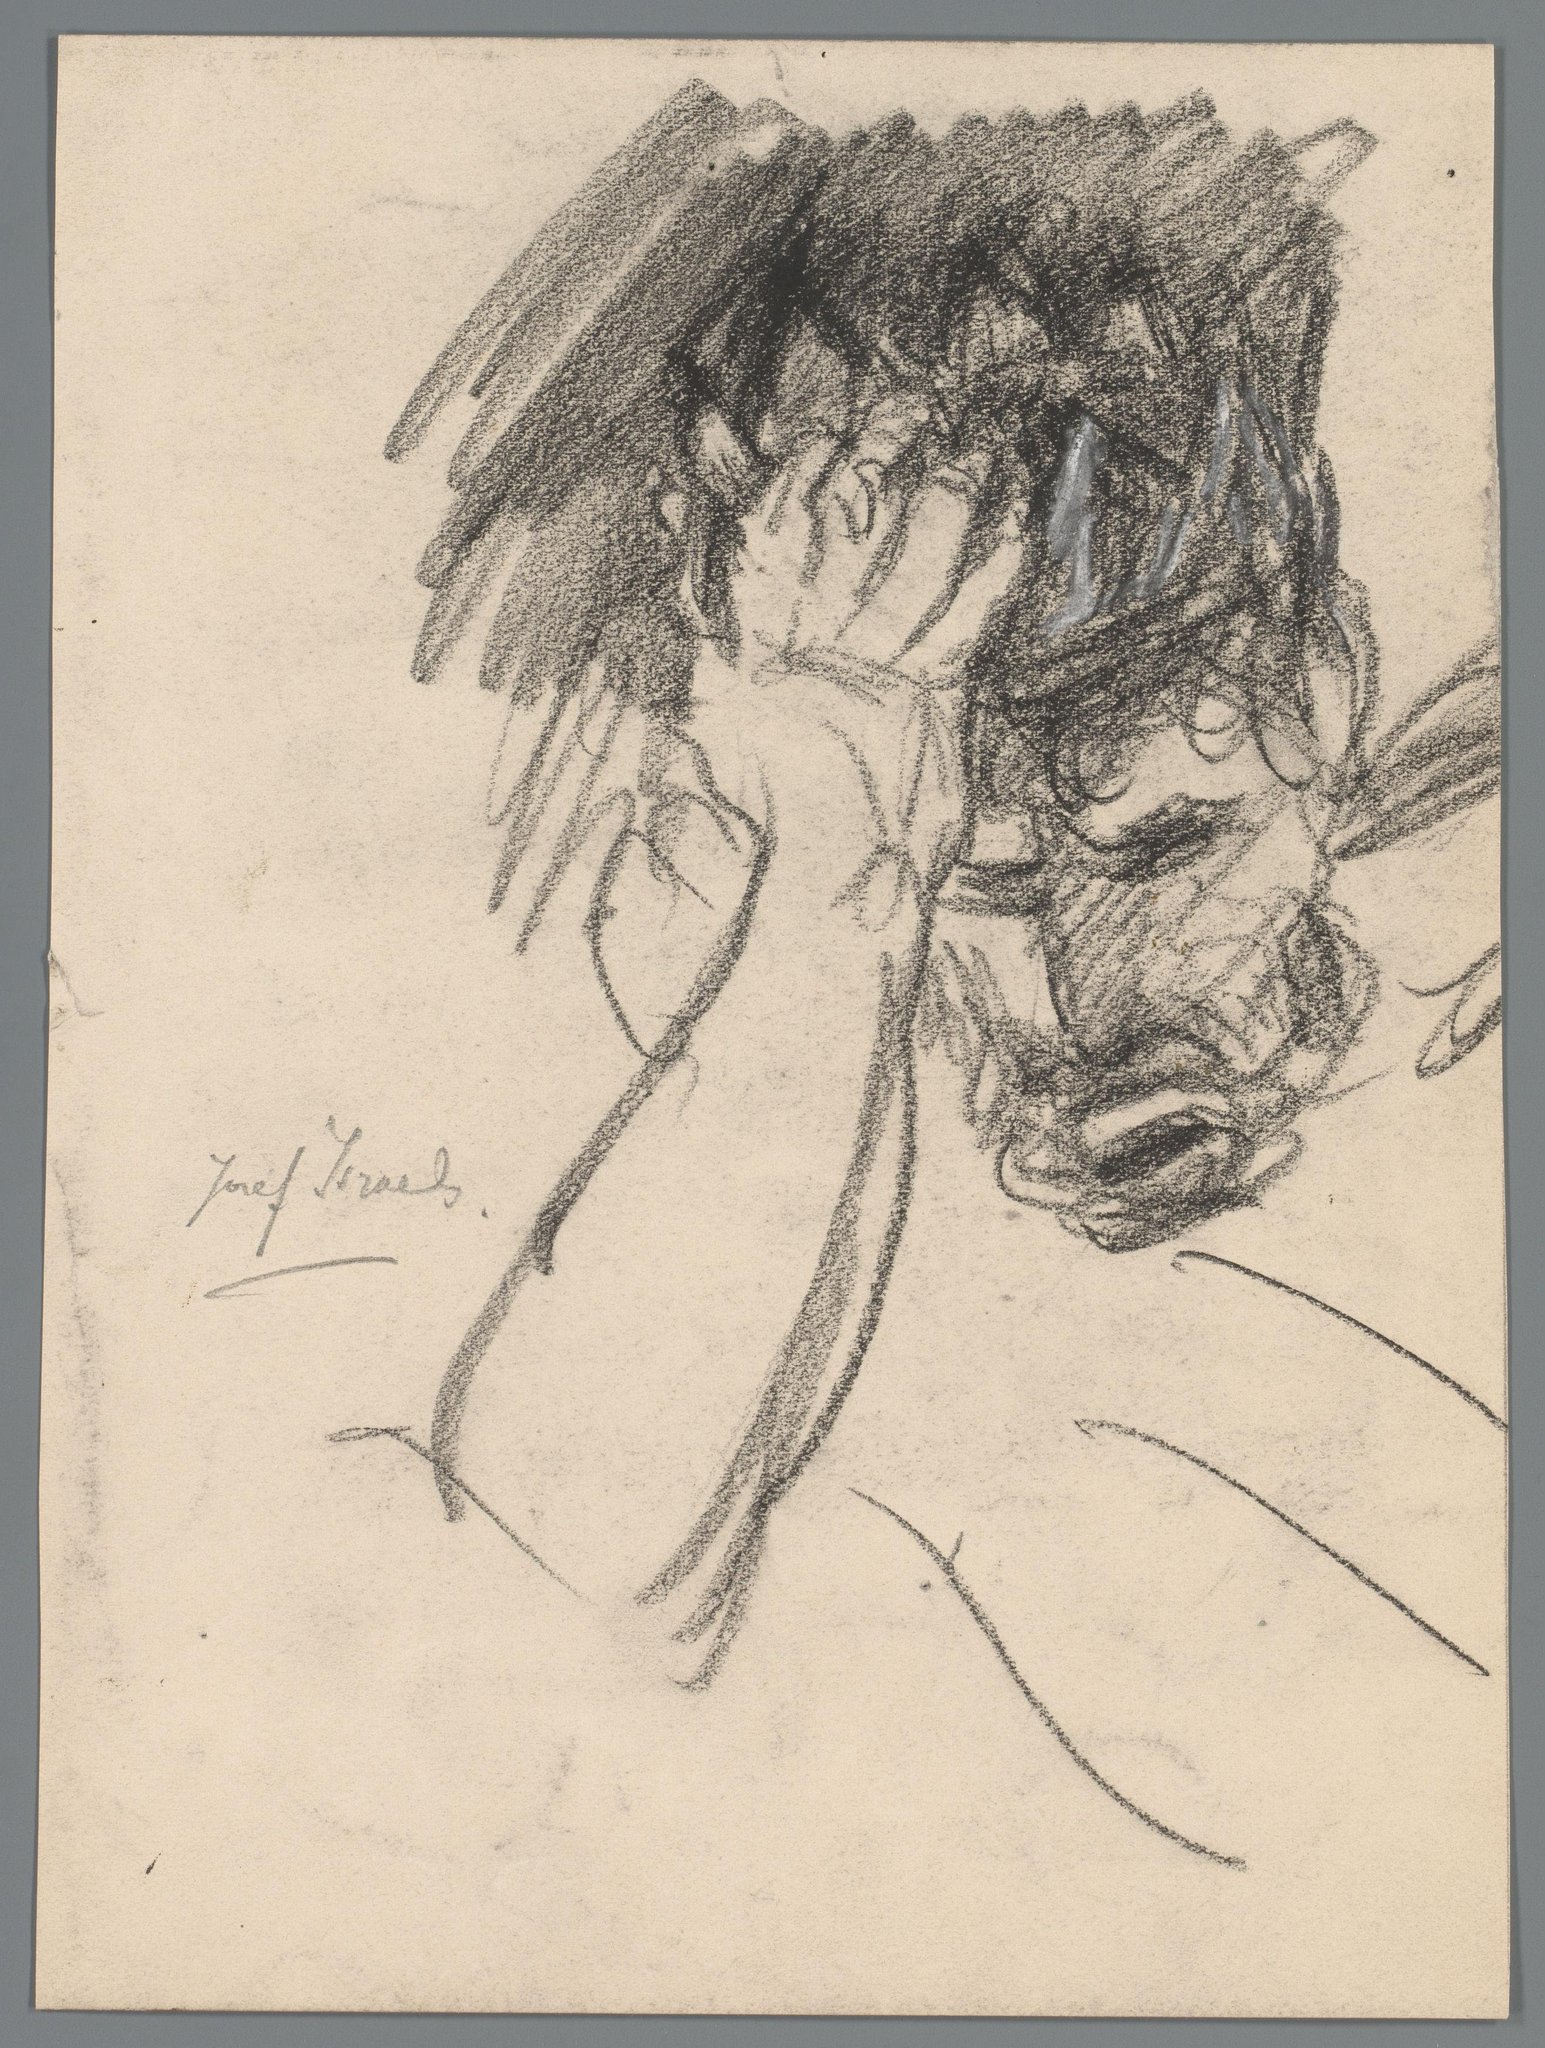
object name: drawing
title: Hoofd van Saul met de rechterhand tegen het voorhoofd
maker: jozef israëls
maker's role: draughtsman, painter, print maker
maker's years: 1824-1911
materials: chalk, paper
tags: crown (symbol of sovereignty), head (human), hand towards the forehead, story of saul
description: Voorstudie voor het schilderij 'David en Saul' dat zich in het Groninger Museum bevindt.